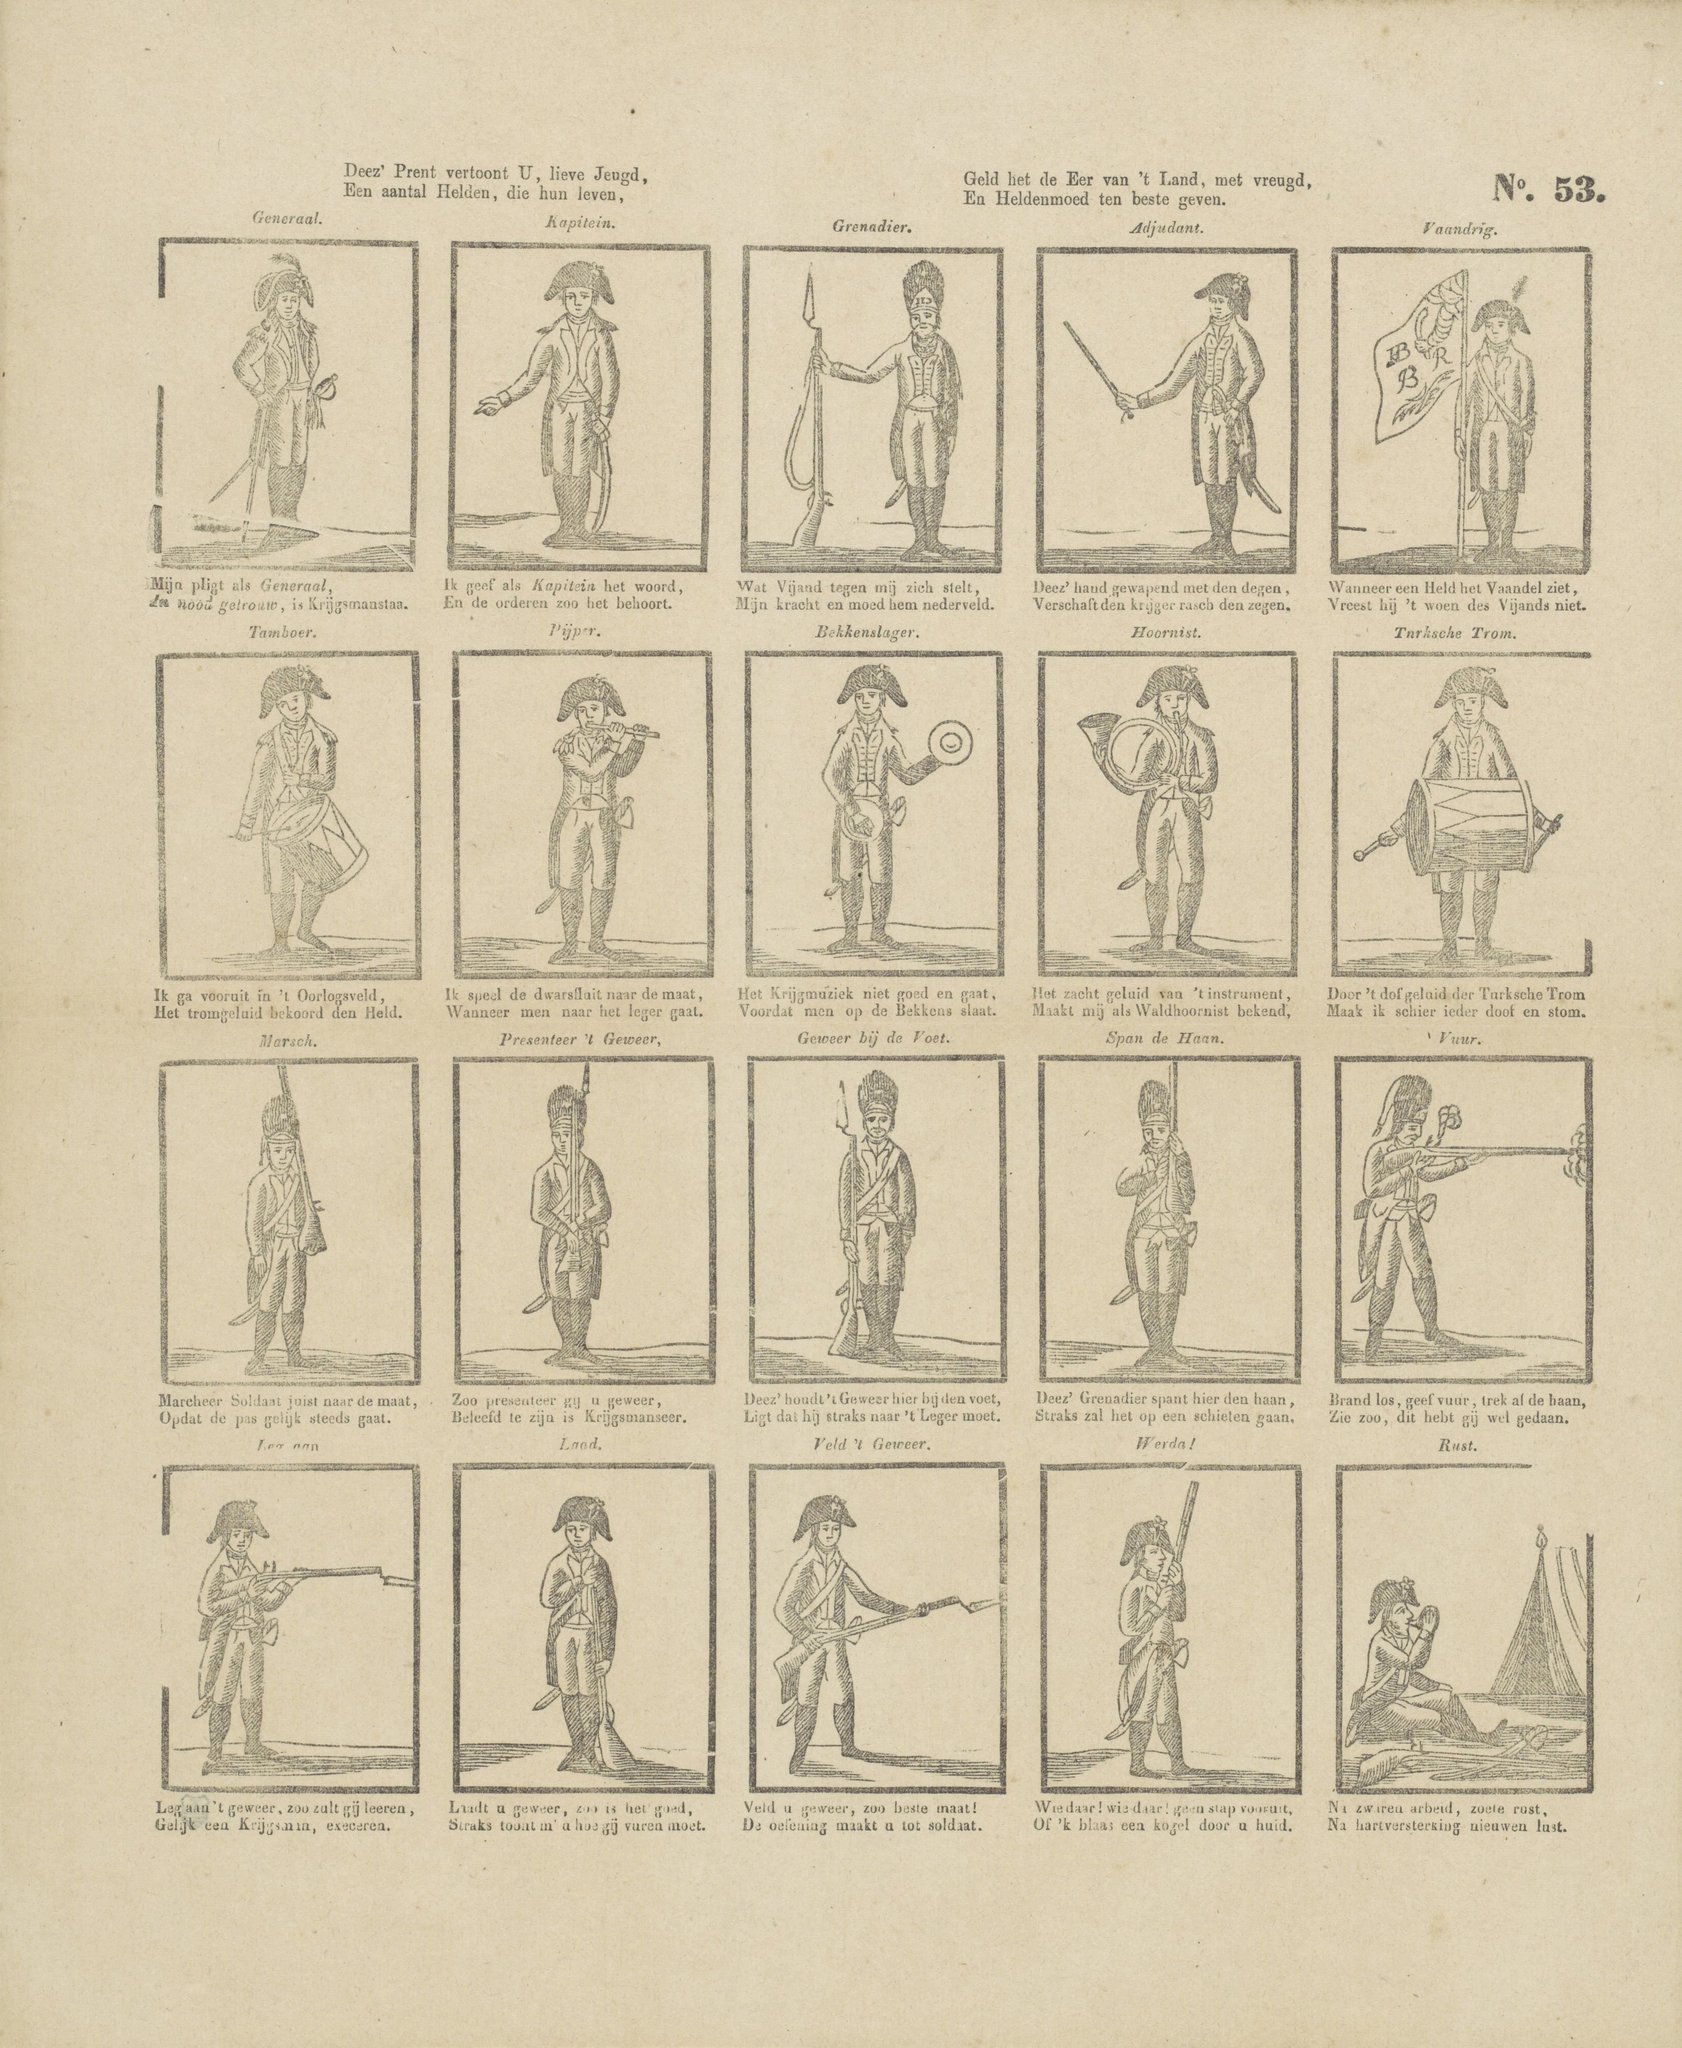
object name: print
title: Deez' prent vertoond u, lieve jeugd. / Een aantal helden, die hun leven. / Geld het de eer van 't land, met vreugd, / En heldenmoed ten beste geven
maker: Anonymous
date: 1850-1870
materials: paper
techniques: letterpress printing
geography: netherlands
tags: military band, the soldier; the soldier's life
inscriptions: collector's mark: Lugt 2760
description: Blad met 20 voorstellingen van militairen. Onder elke afbeelding een tweeregelig vers. Genummerd rechtsboven: No. 53.